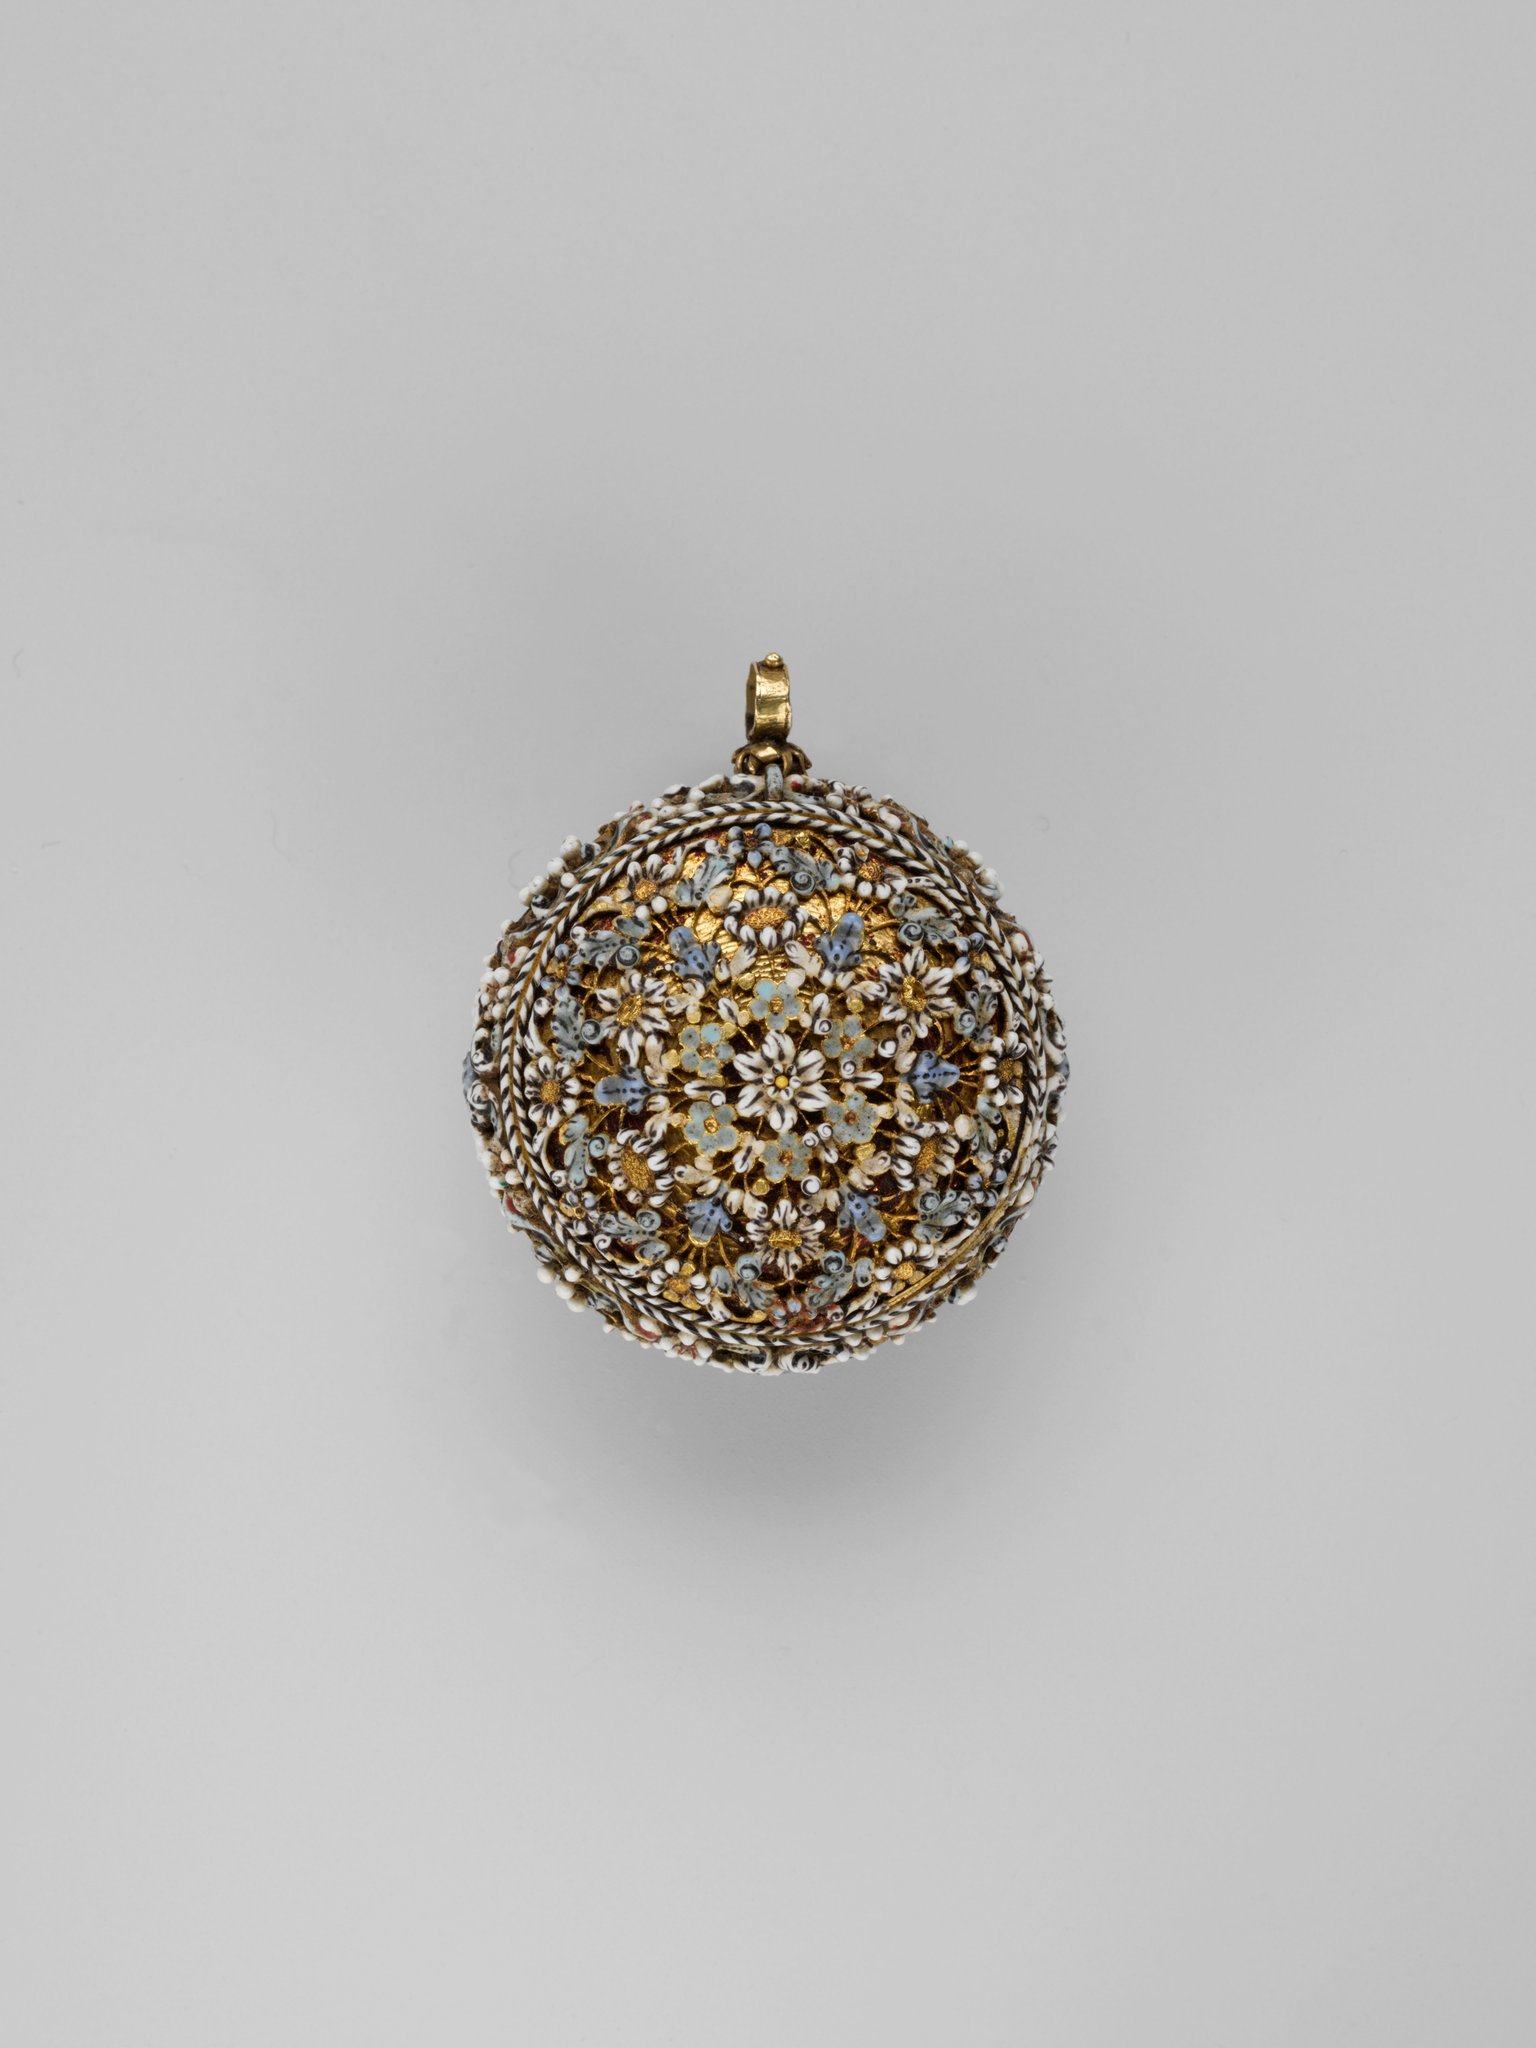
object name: watch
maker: nicolas bernard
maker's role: maker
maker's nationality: french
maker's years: 1530-1620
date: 1501-1600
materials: enamel, gold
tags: flowers